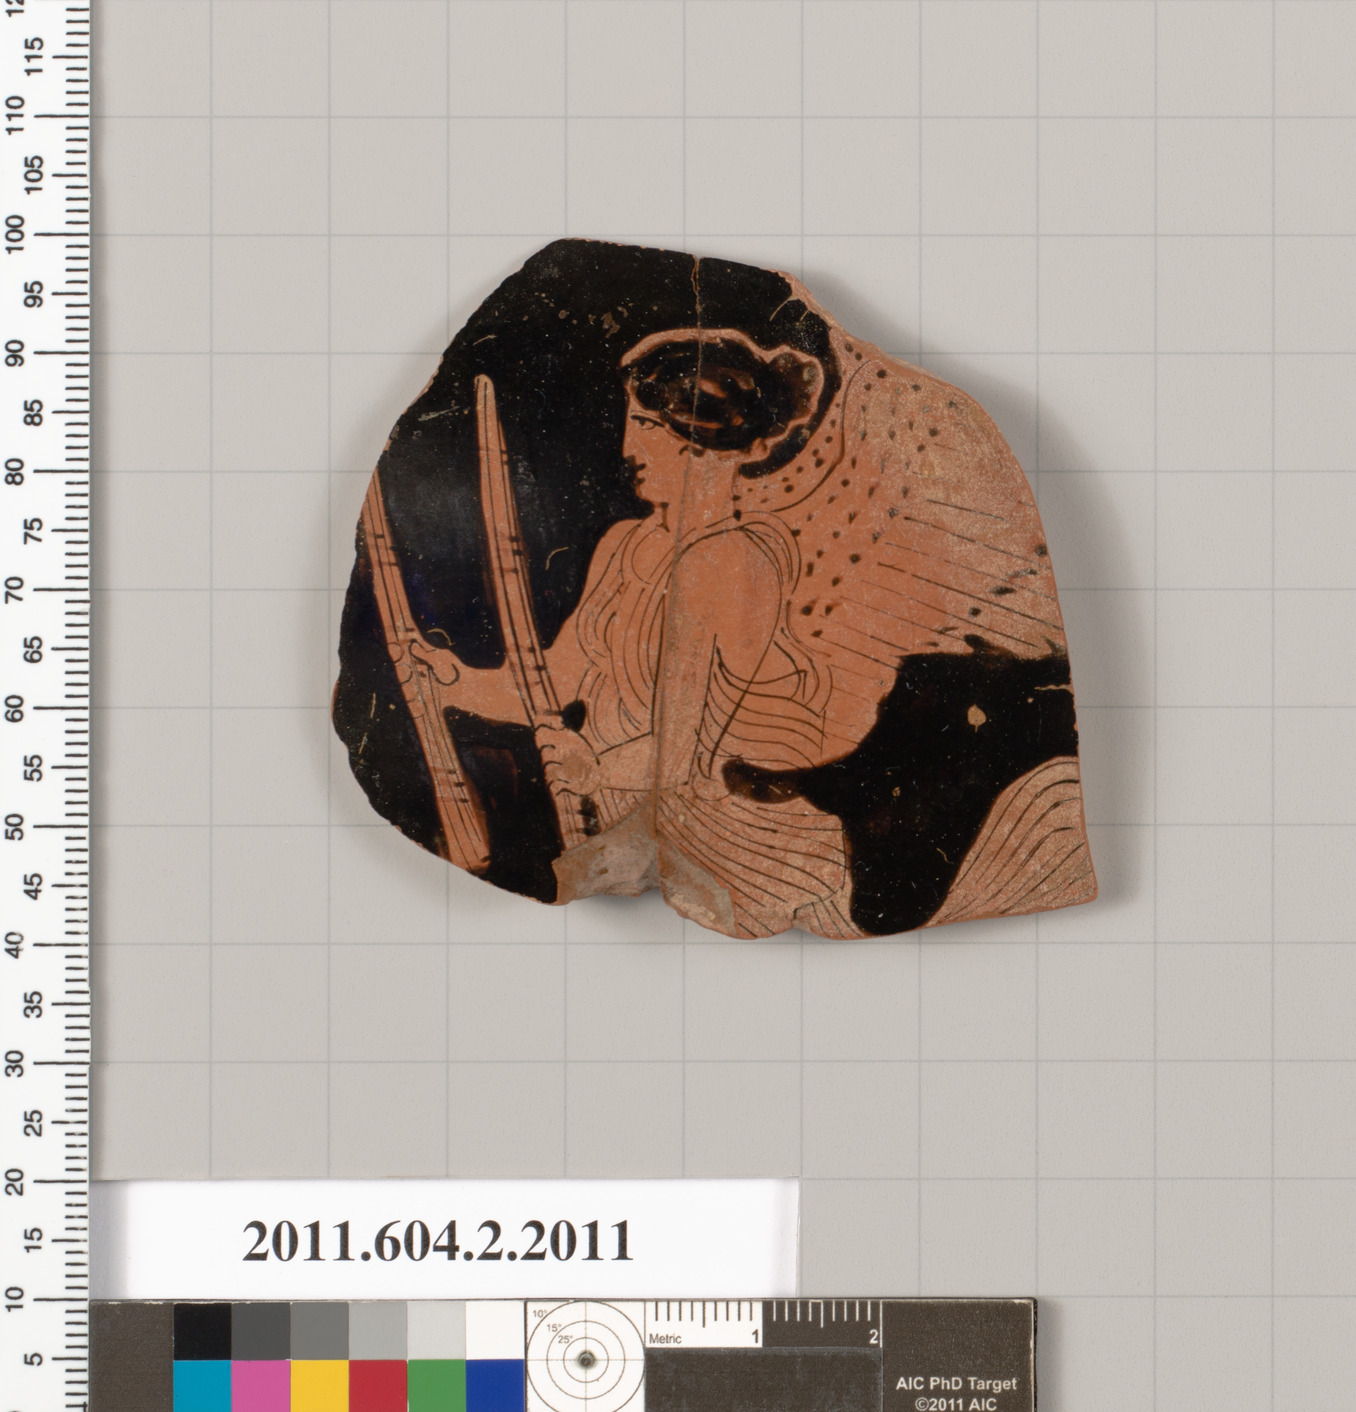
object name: chou fragment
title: Terracotta fragment of an oinochoe: chous (jug)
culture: greek, attic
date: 467-435 BCE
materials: terracotta